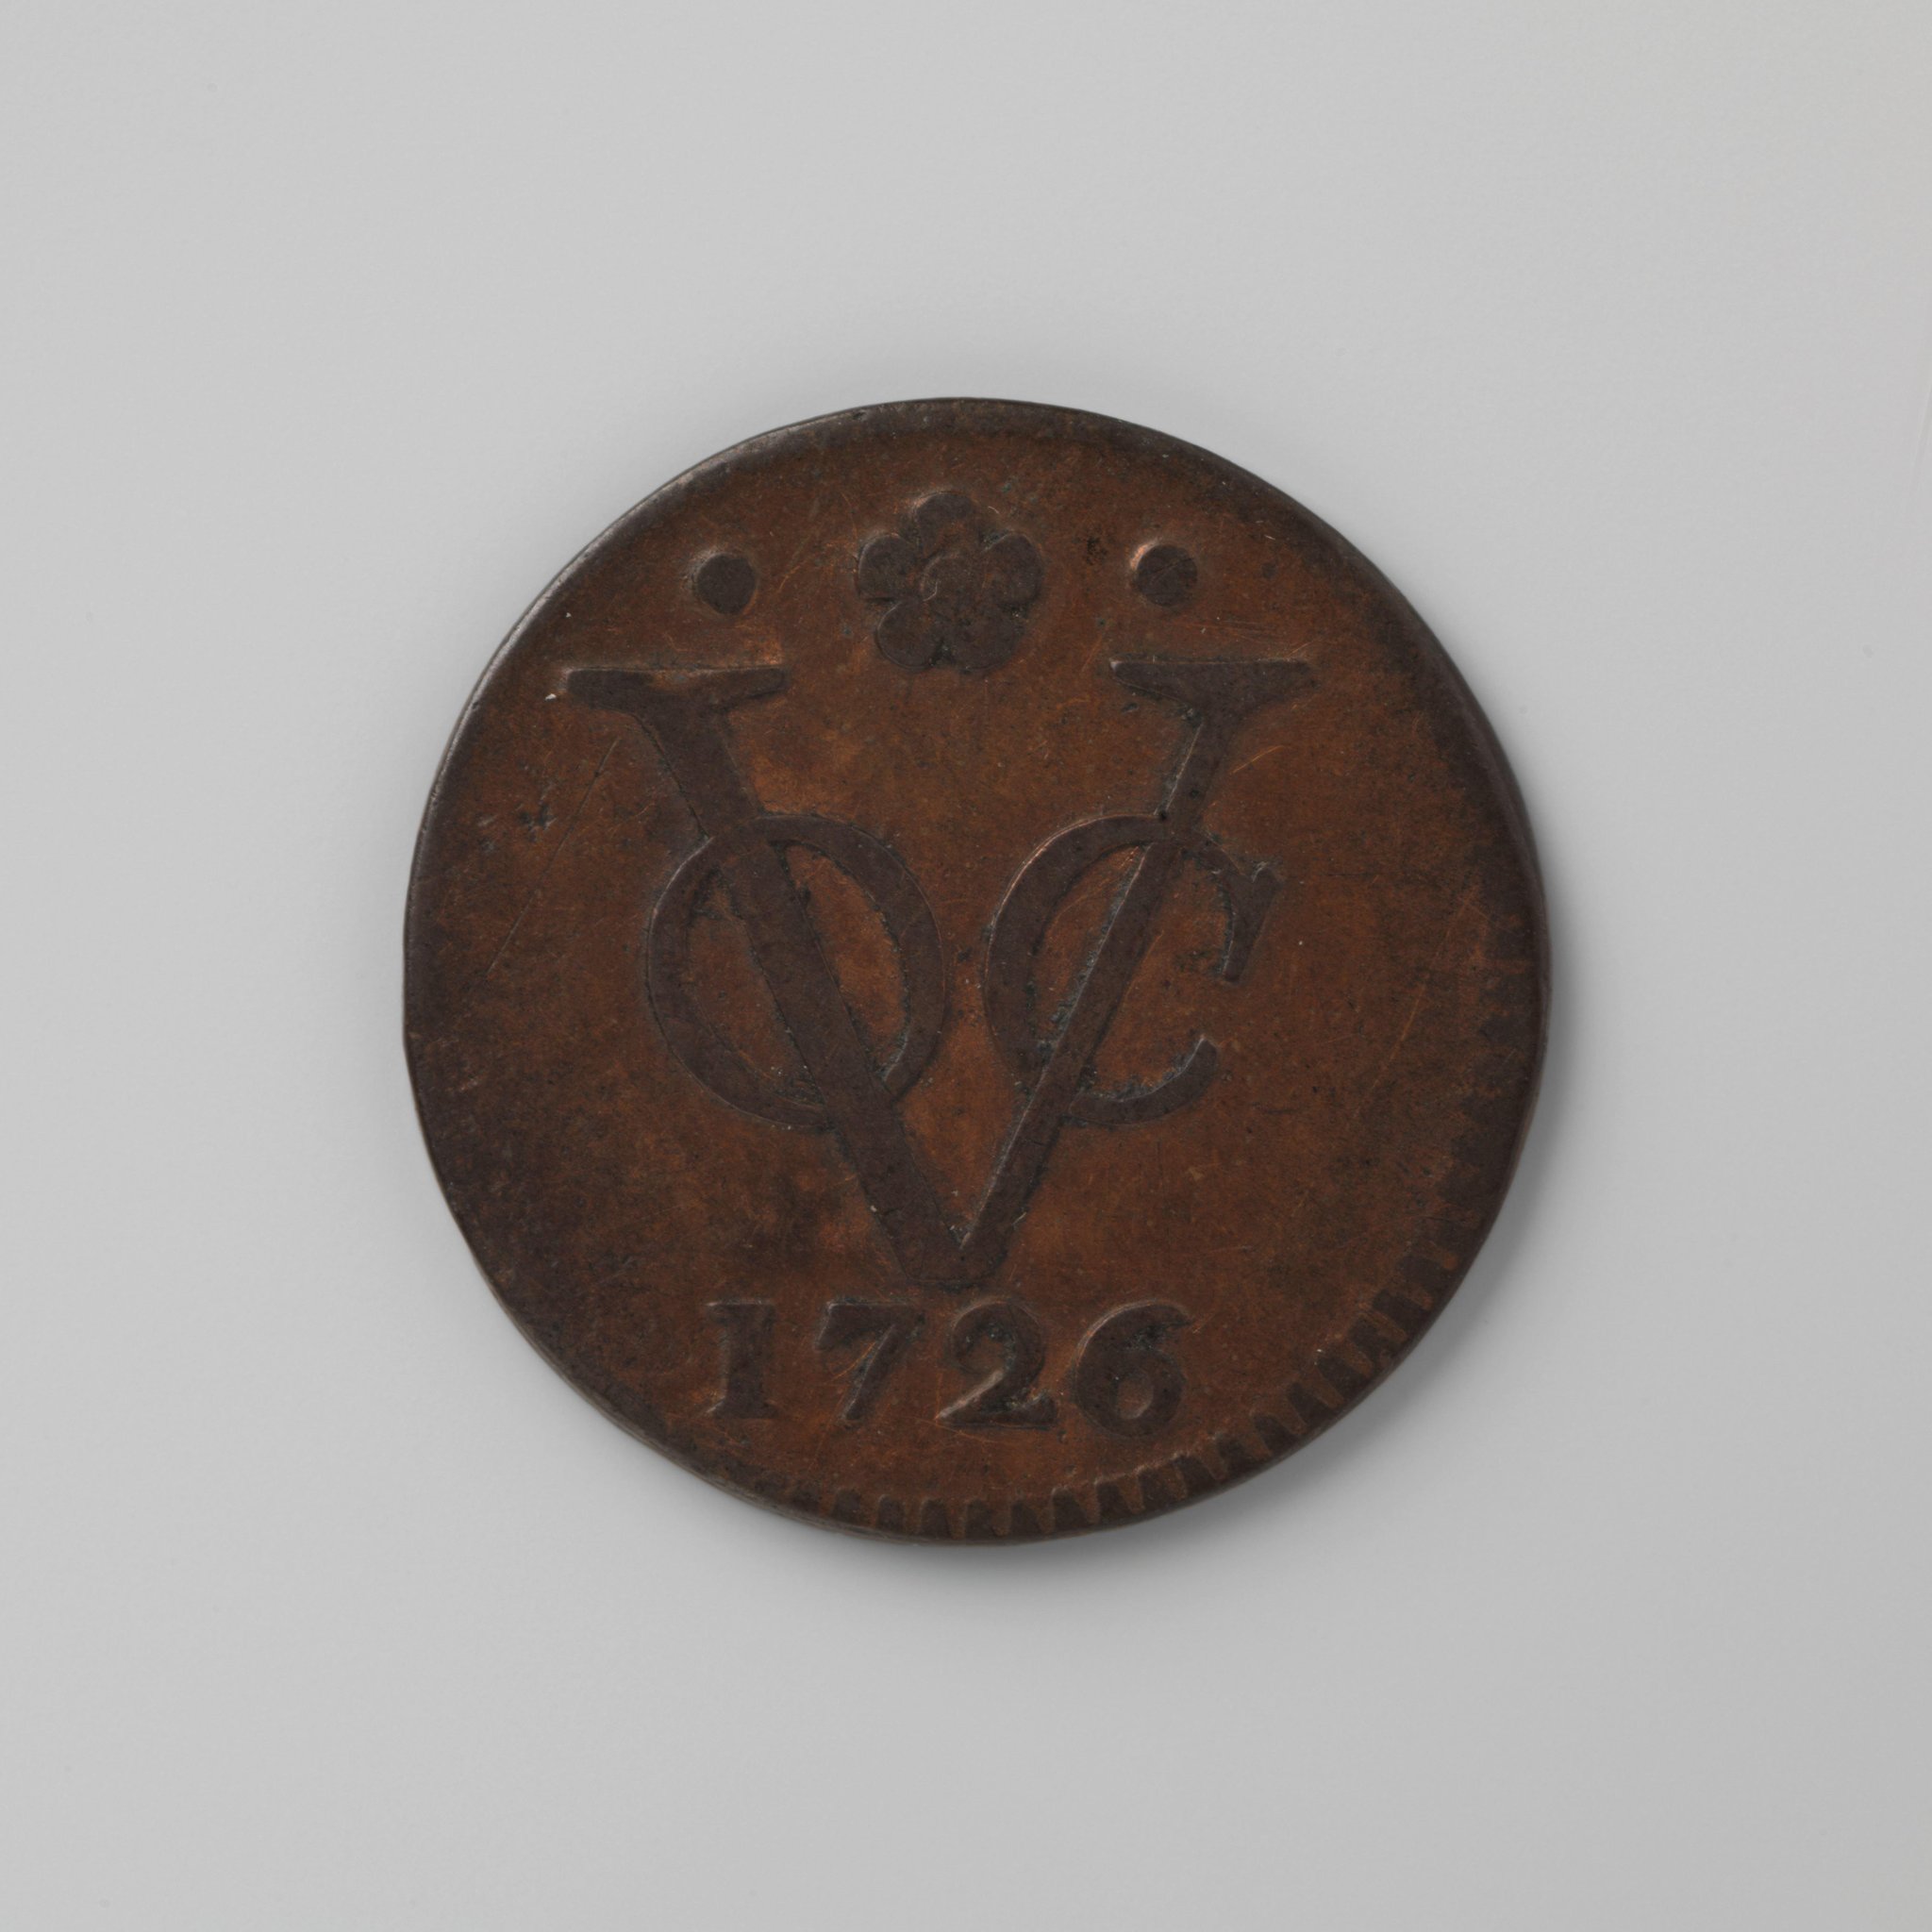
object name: coin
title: VOC, duit Holland, 1726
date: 1726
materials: copper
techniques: striking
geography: dordrecht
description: Koperen munt. Voorzijde: gekroond wapenschild van Holland. Keerzijde: monogram van de VOC, waarboven muntteken en waaronder jaartal. Gladde rand.